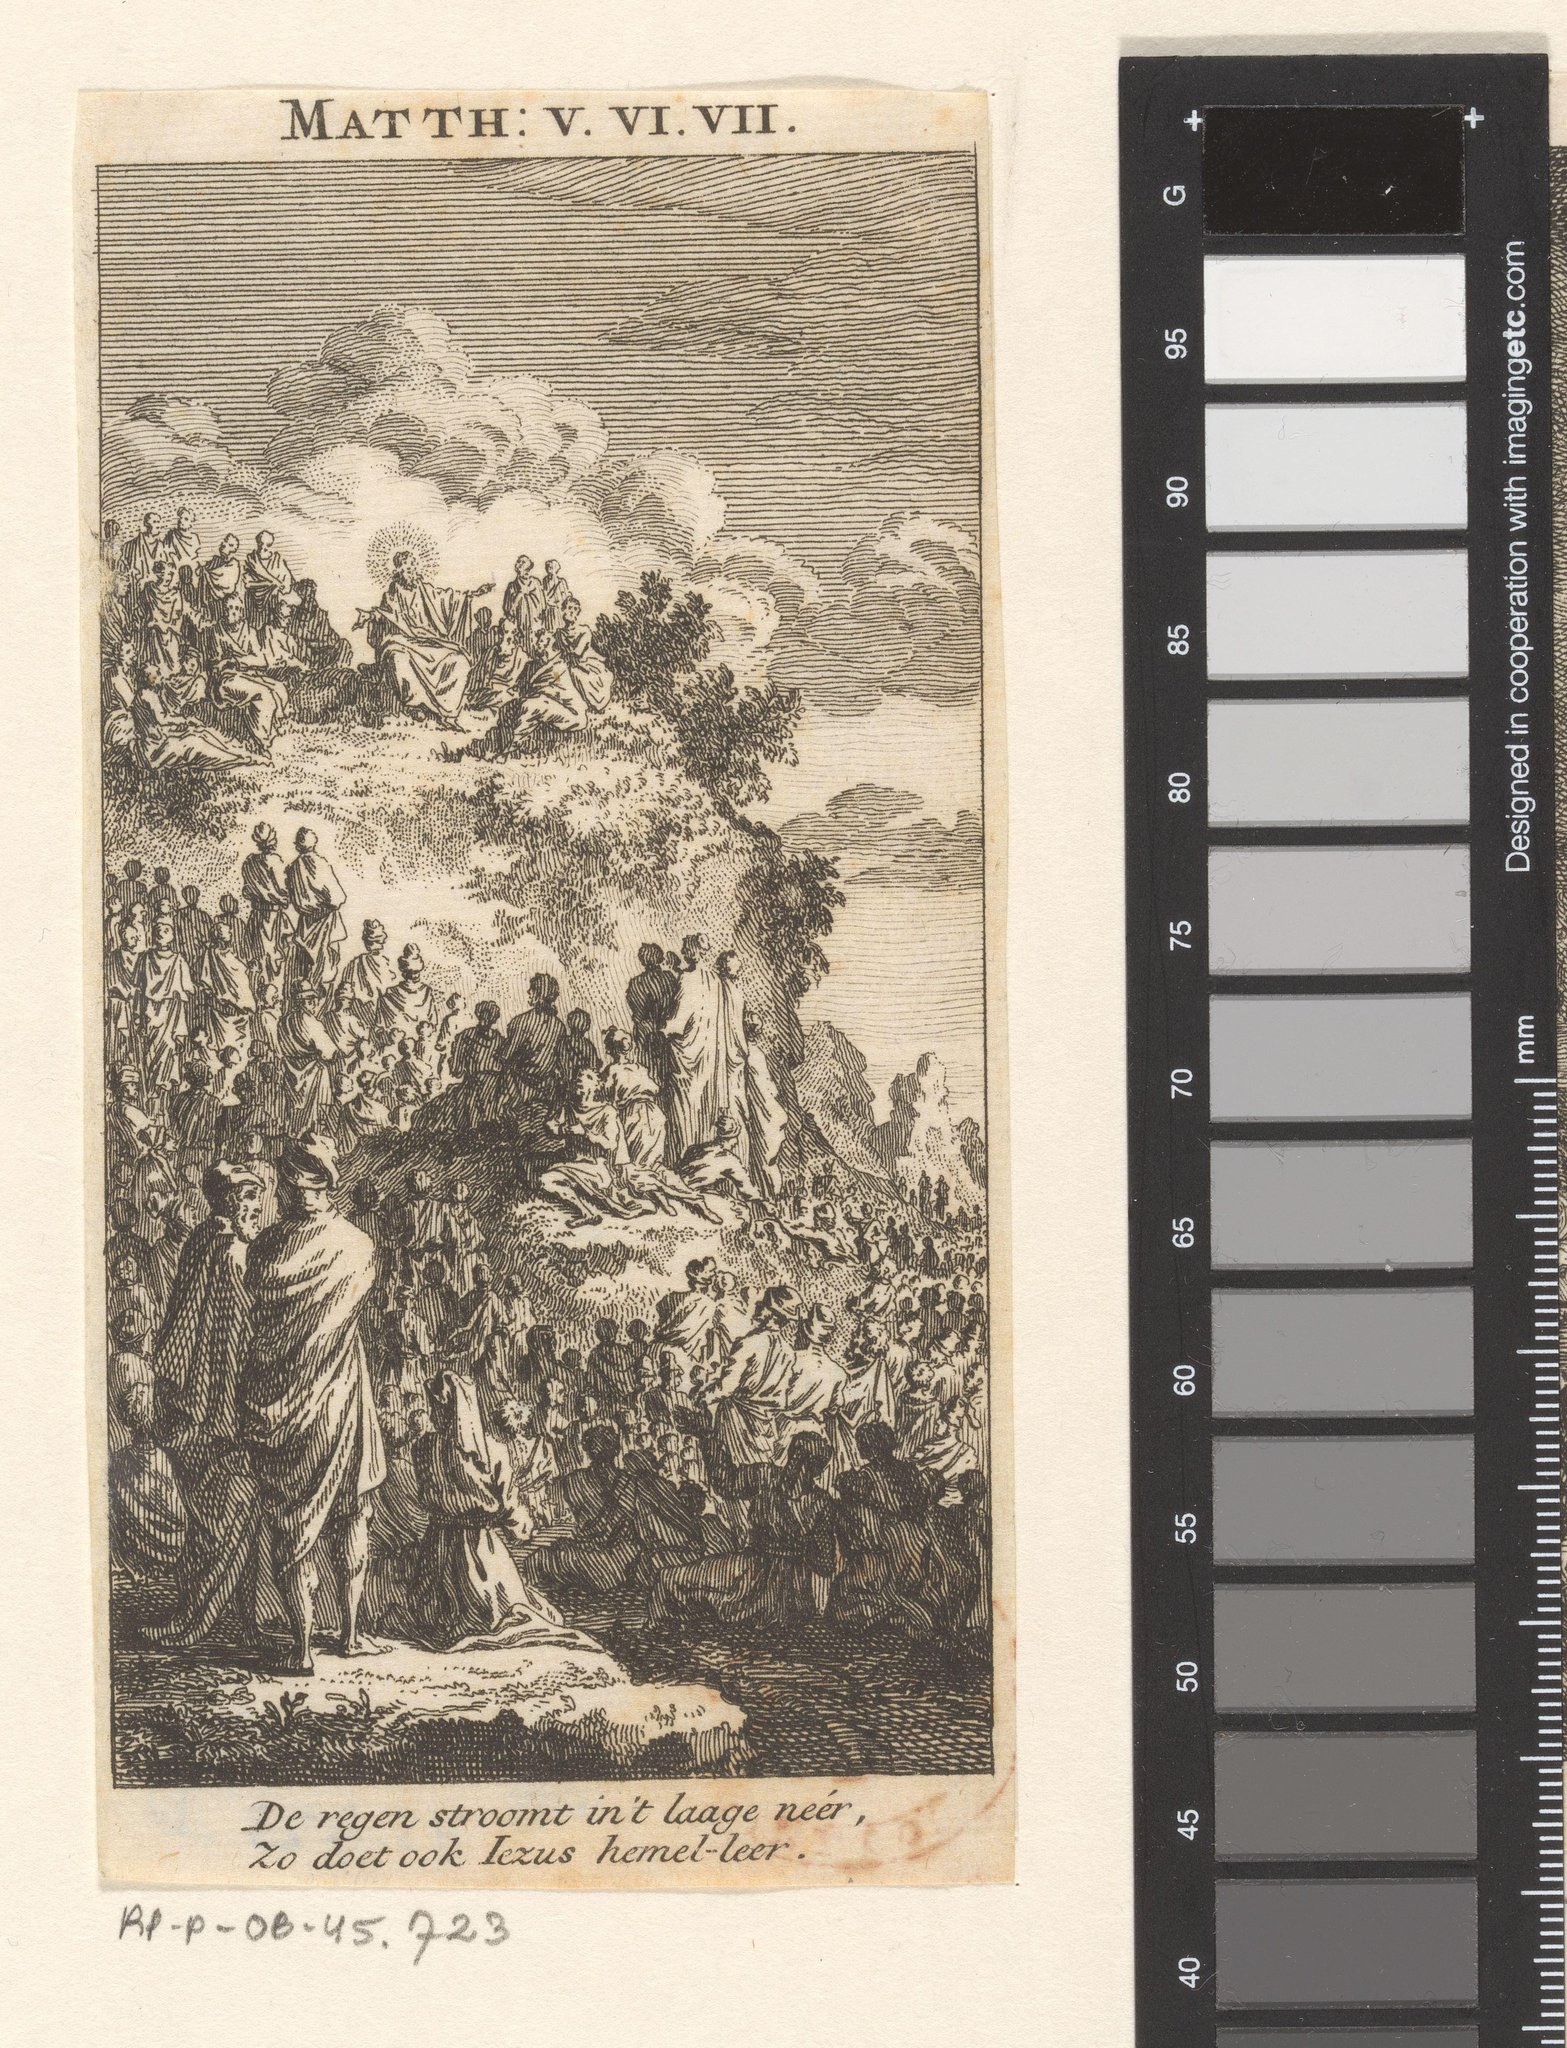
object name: print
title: Bergrede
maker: Anonymous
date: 1712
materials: paper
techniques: etching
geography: amsterdam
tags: christ's sermon on the mount (matthew 5-7)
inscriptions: collector's mark: Lugt 240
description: Kopie naar illustratie voor: Luyken, Jan. Bybel printen. Amsterdam: Pieter Arentsz. II (wed.) en Cornelis van der Sys, 1712, p. 18.